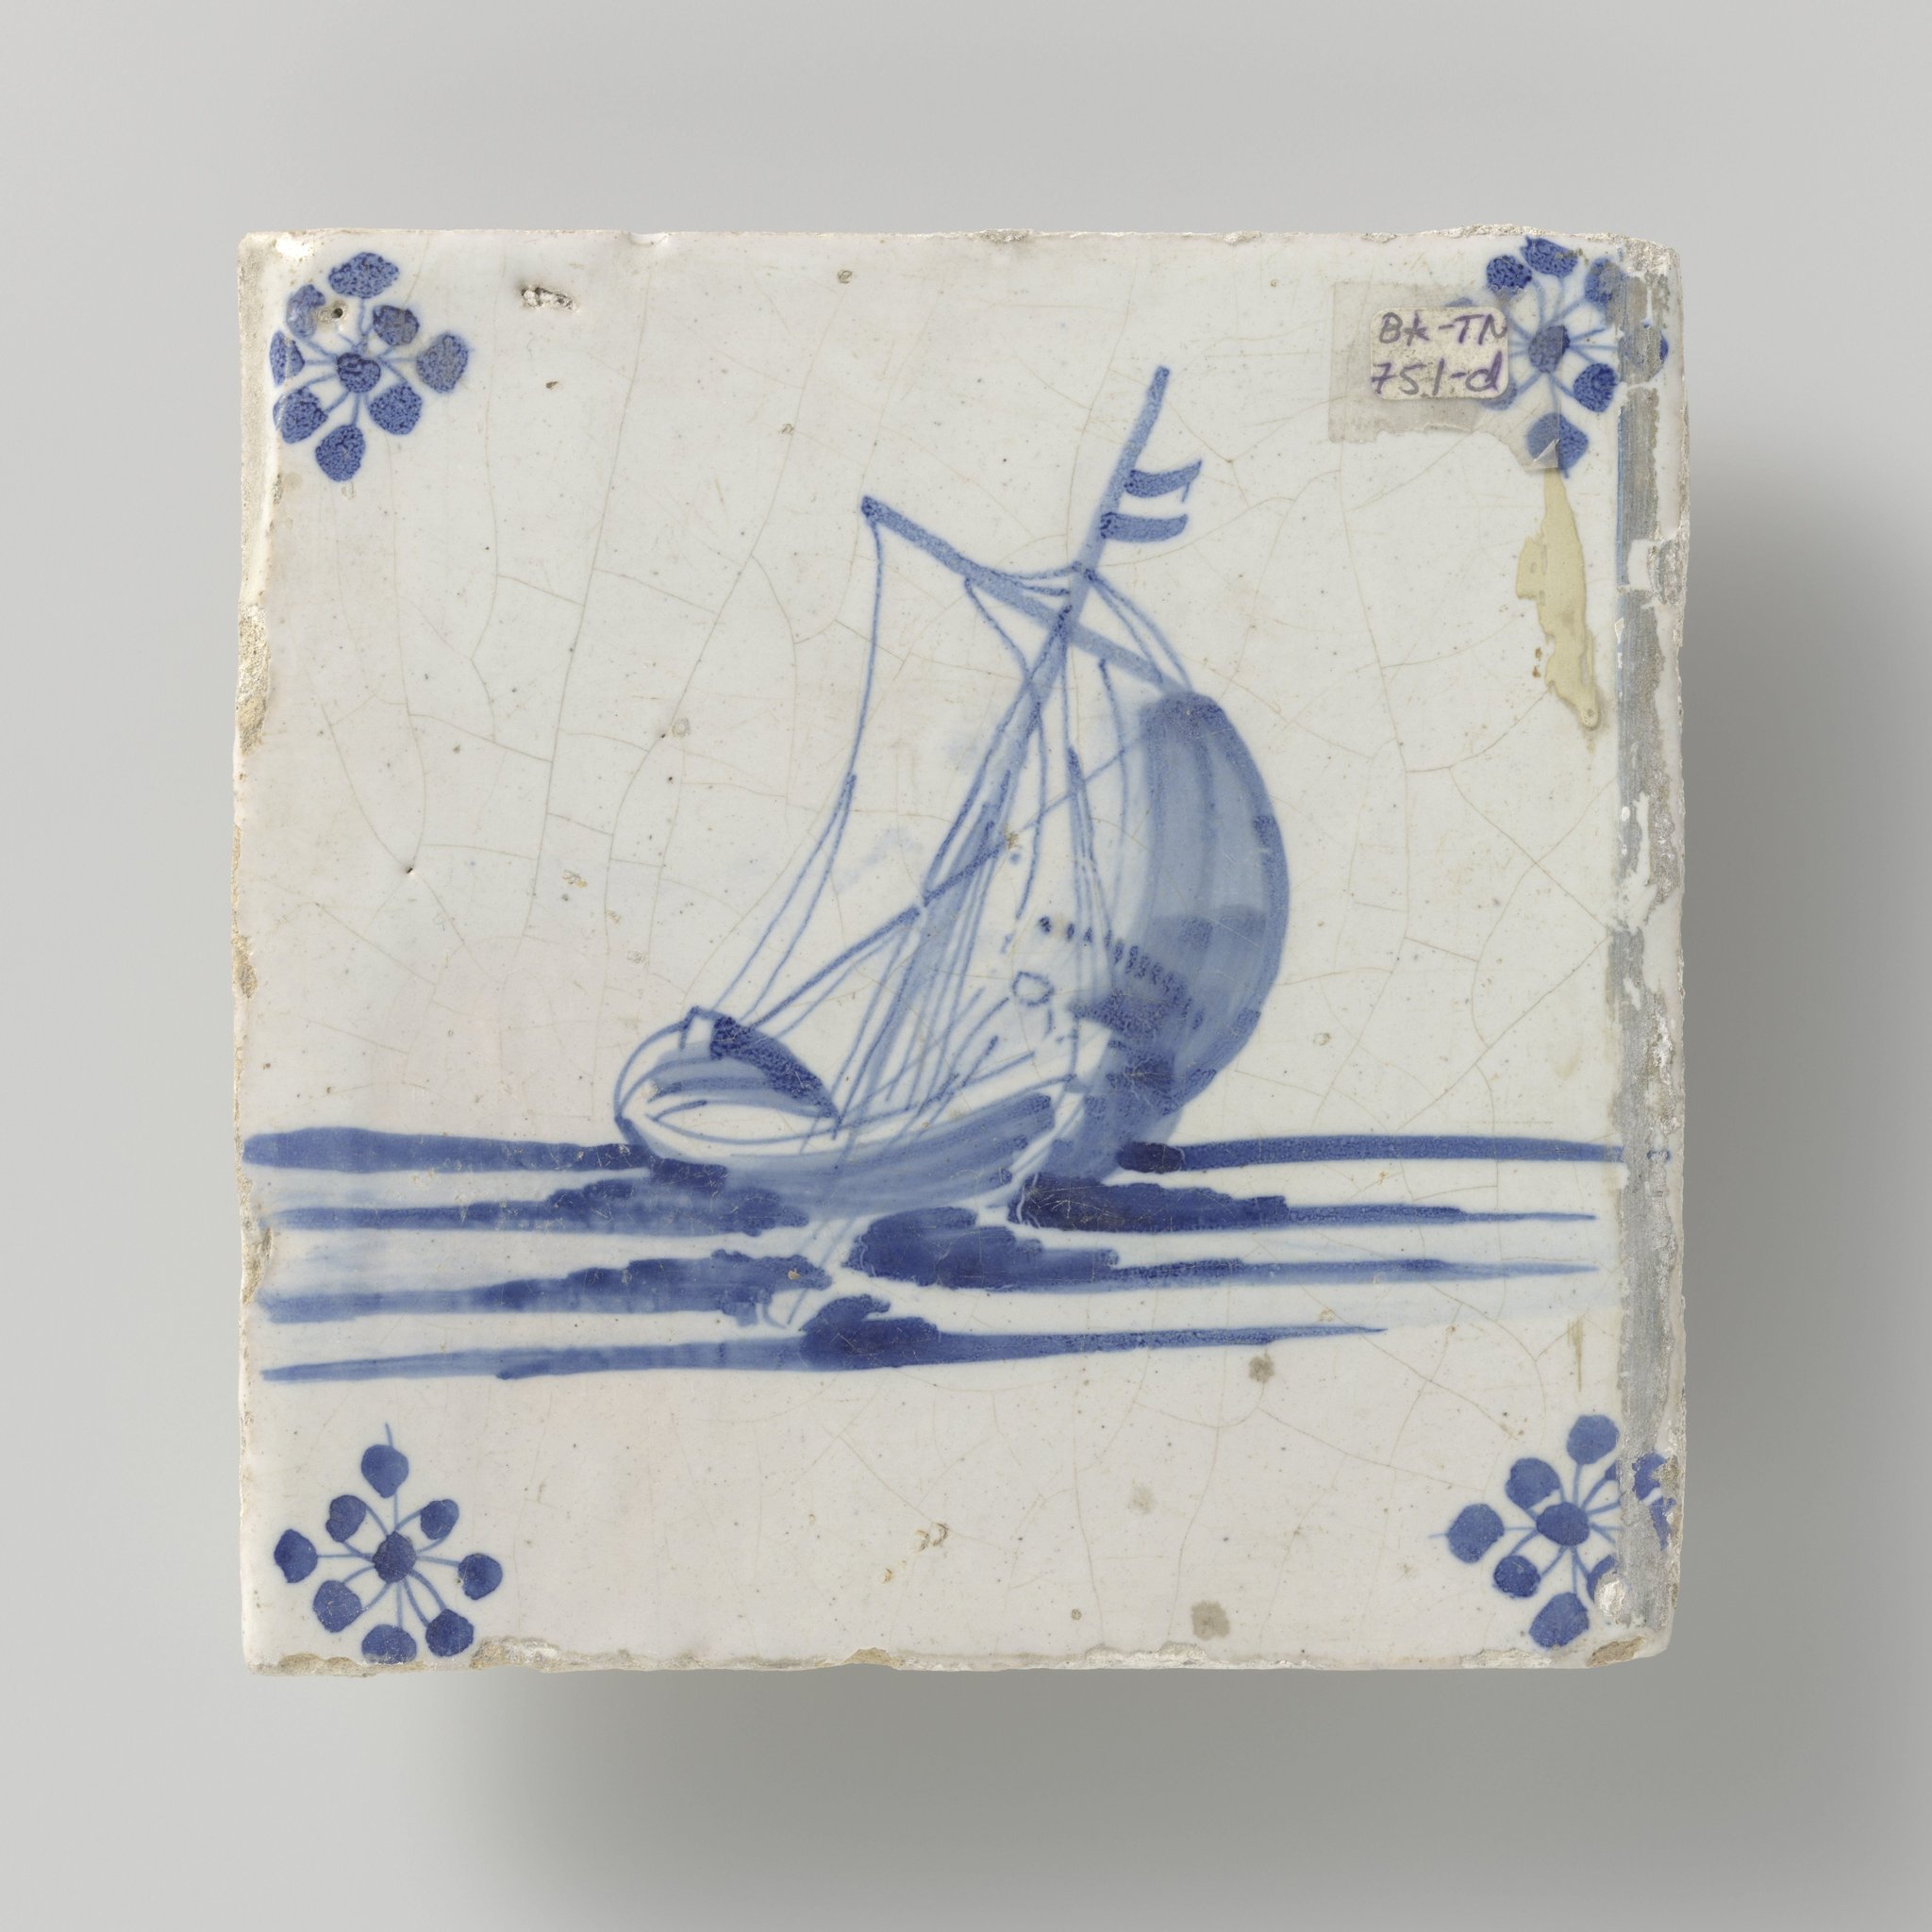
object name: tile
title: Tegel, blauw beschilderd met een schip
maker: Anonymous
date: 1650-1680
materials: earthenware, glaze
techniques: maiolica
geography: netherlands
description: Tegel, blauw beschilderd met een schip, zogenaamd boerenscheepje. In de hoeken een spinnekop.